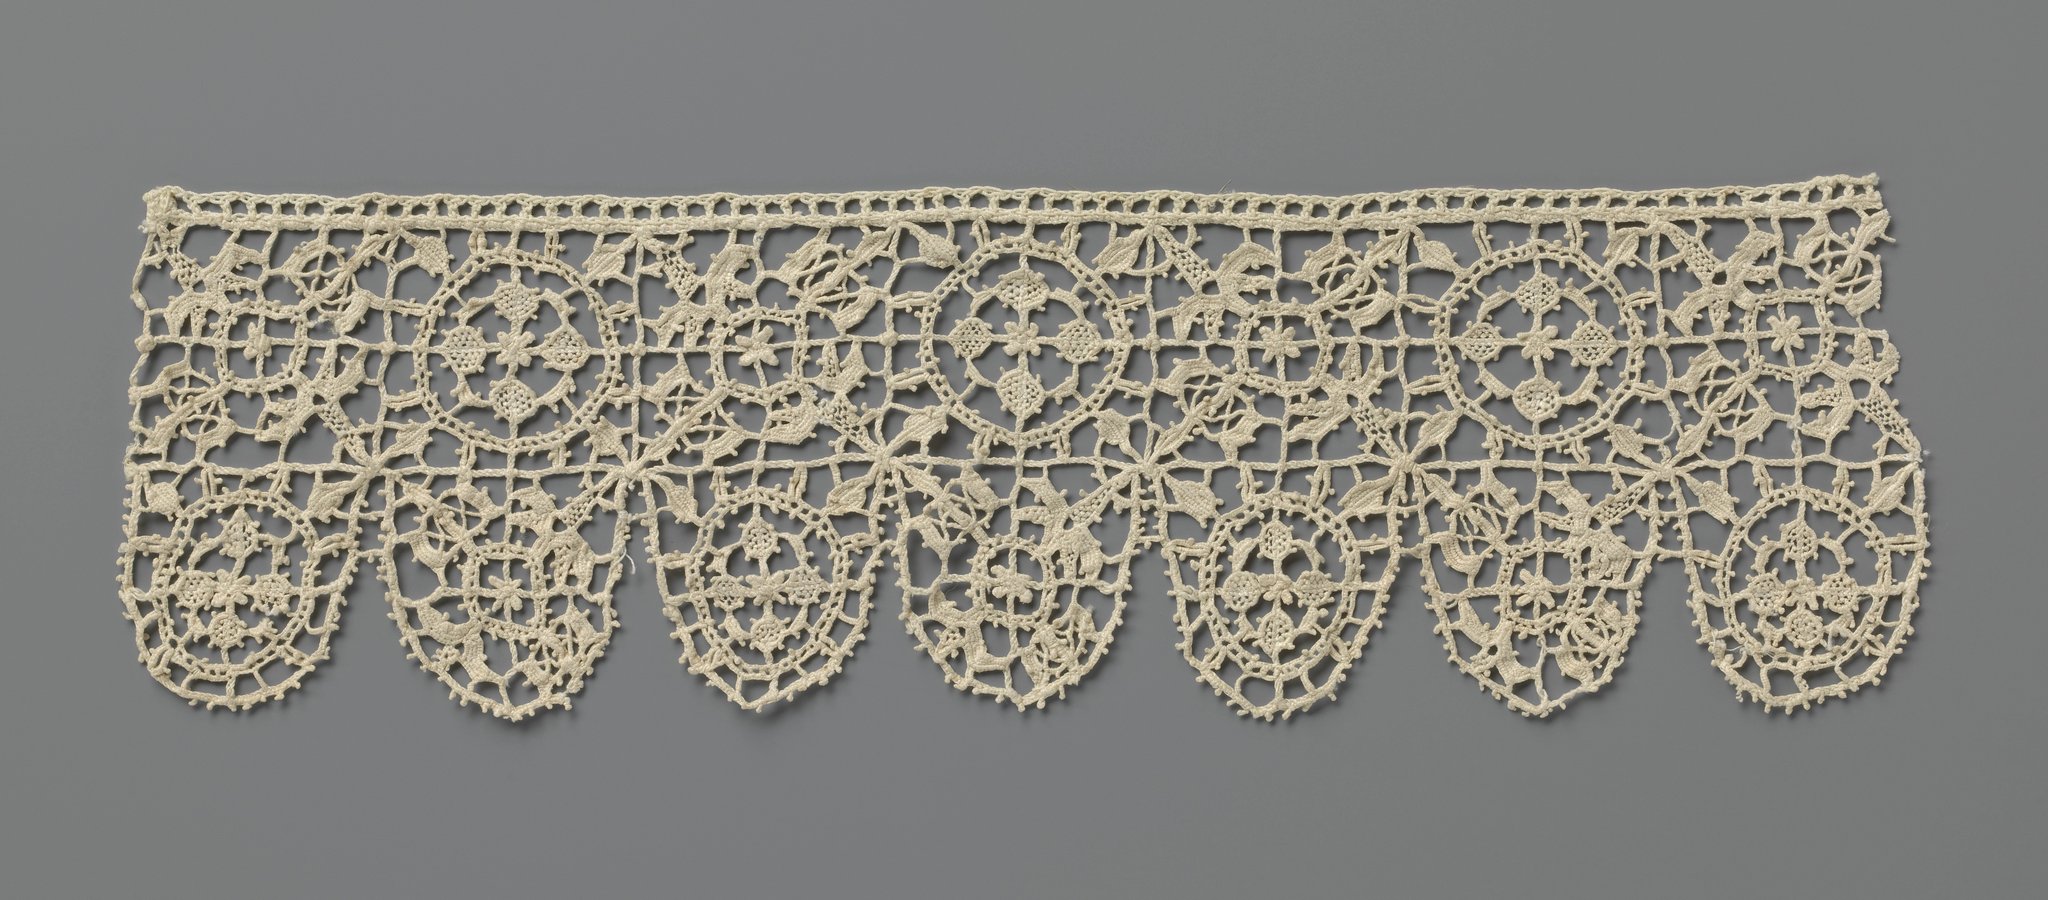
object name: strip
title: Strook naaldkant met twee soorten rozetten in vierkanten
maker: Anonymous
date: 1600-1609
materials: linen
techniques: needle lace, reticella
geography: italy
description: Strook naturelkleurig naaldkant: reticella. De bovenzijde van het patroon bestaat uit vierkanten, die zijn opgebouwd uit vier kleine vierkanten. In de vierkanten staan afwisselend een kleine en een grote cirkel. Rond de kleine cirkel staan in de hoeken bloemen. Rond de grote cirkel staan in de hoeken blaadjes. Dit patroon verspringt en herhaalt zich in de onderzijde van de strook, de vierkanten zijn hier echter aan zijkant en onderkant afgerond tot een schulpenrand met halfcirkelvormige diepe schulpen. De bovenzijde van de strook is afgewerkt met een smalle rechte rand met vierkantjes.